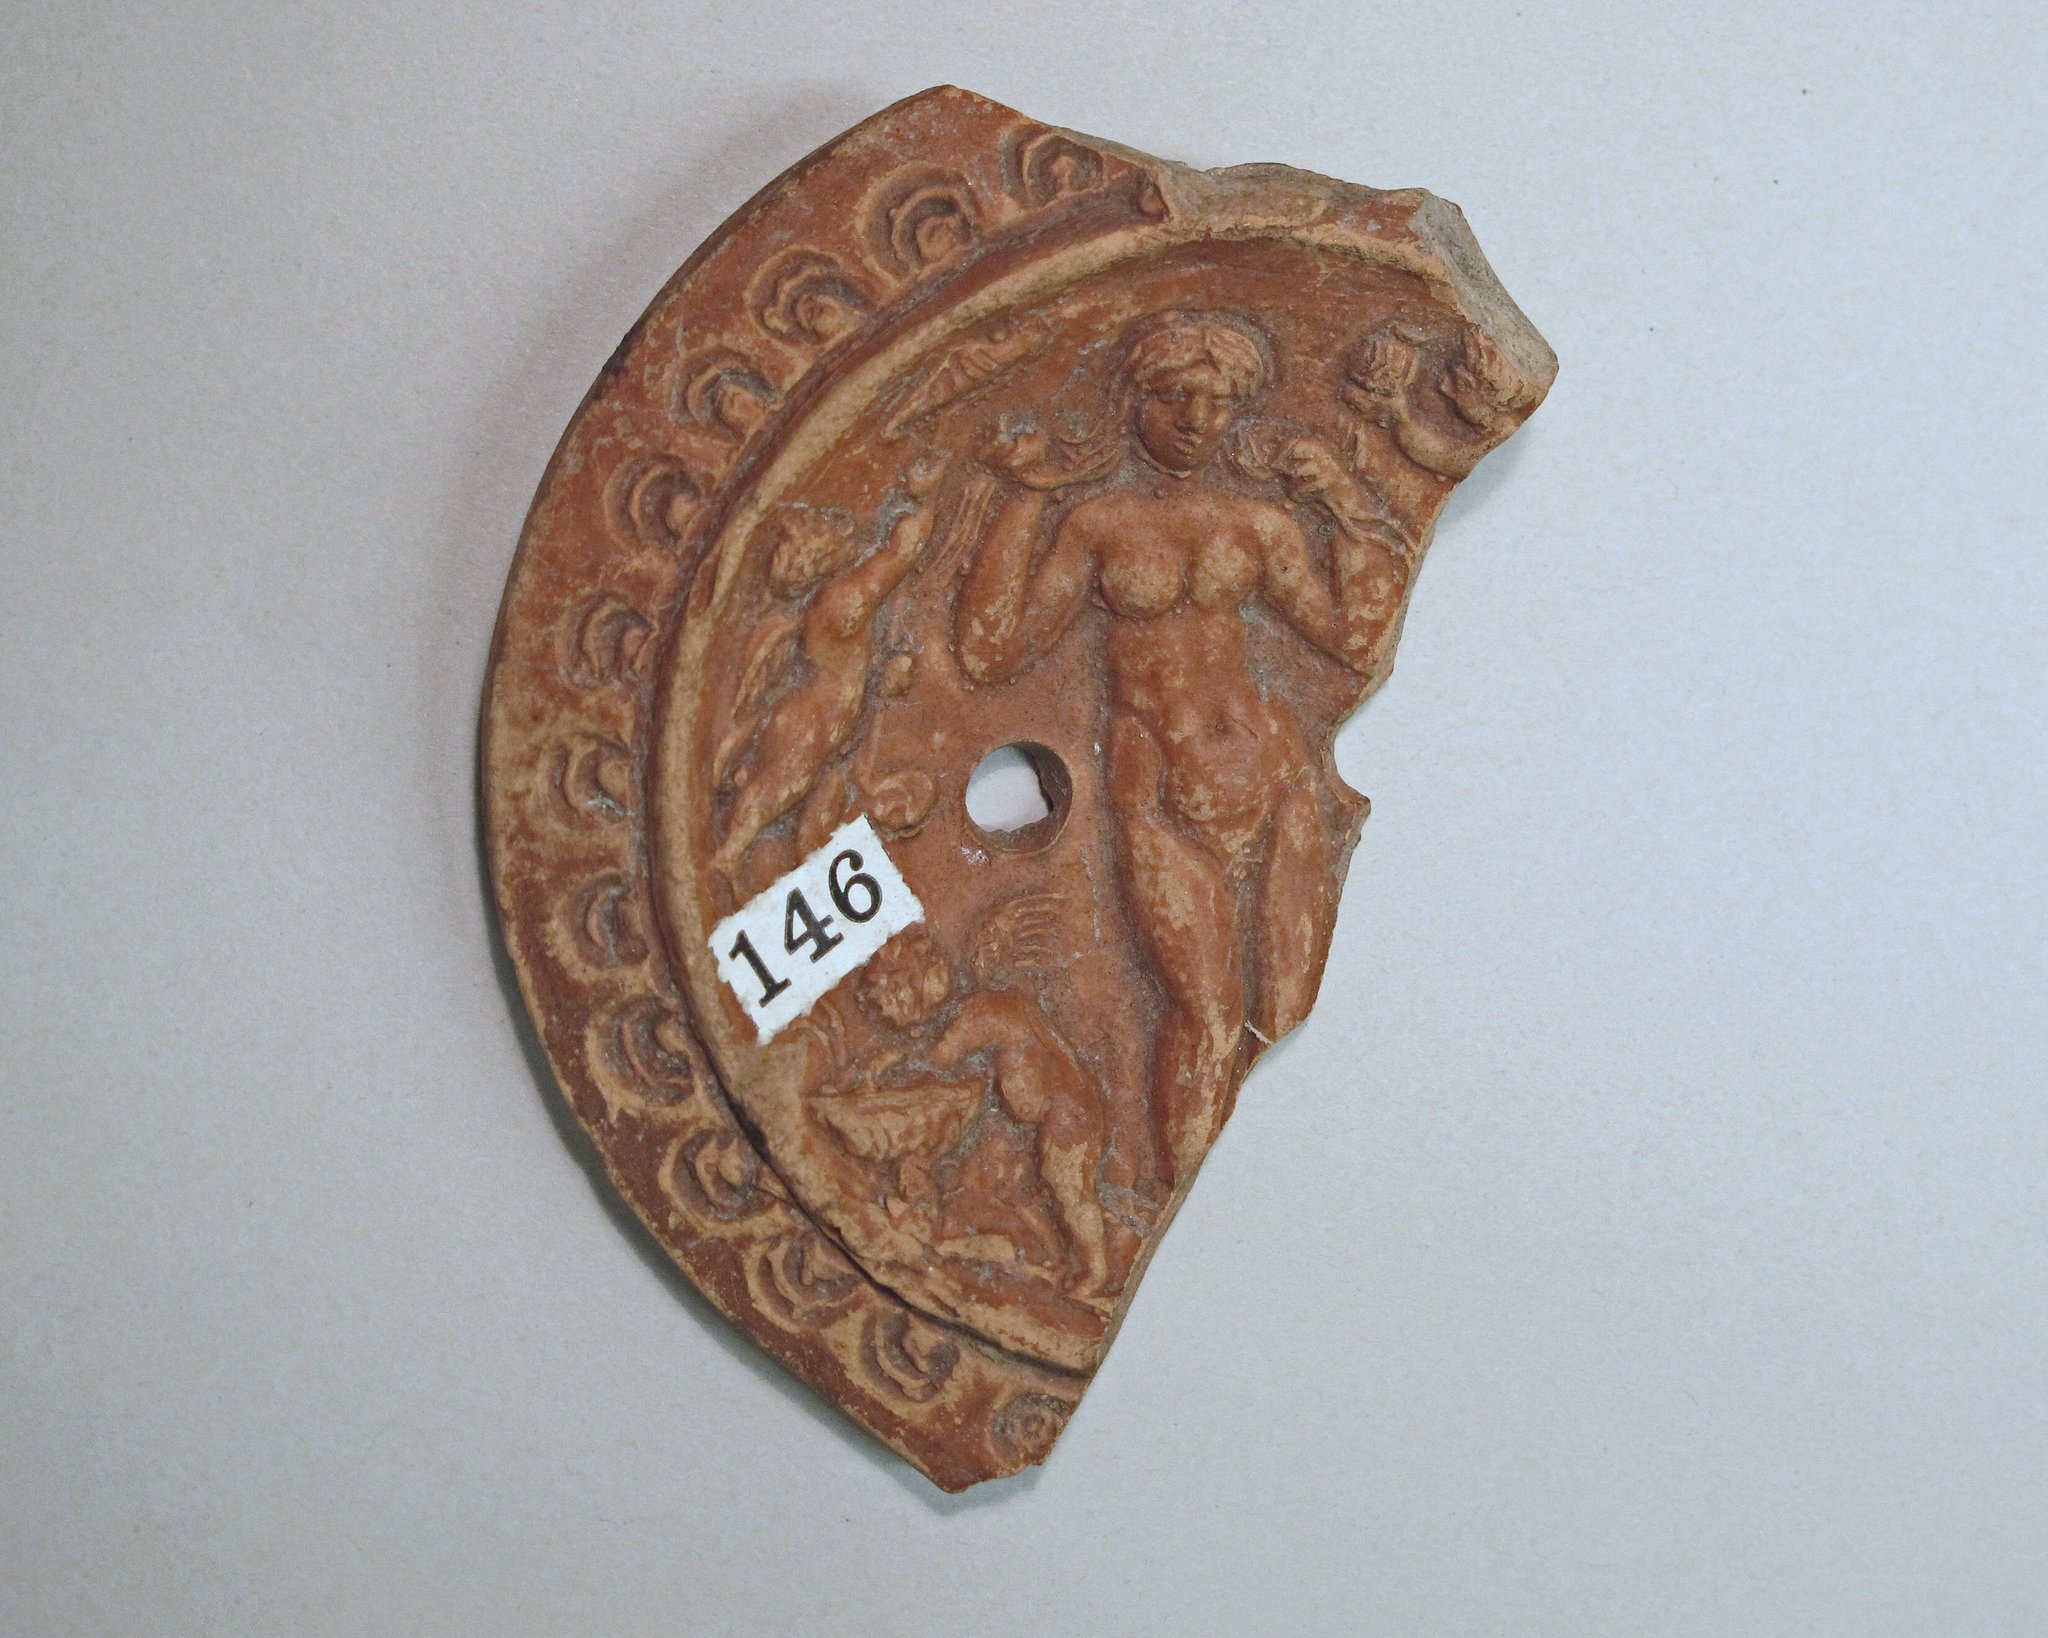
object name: lamp fragment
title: Terracotta lamp fragment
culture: roman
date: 120 BCE-300 CE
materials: terracotta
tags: women,female nudes,eros